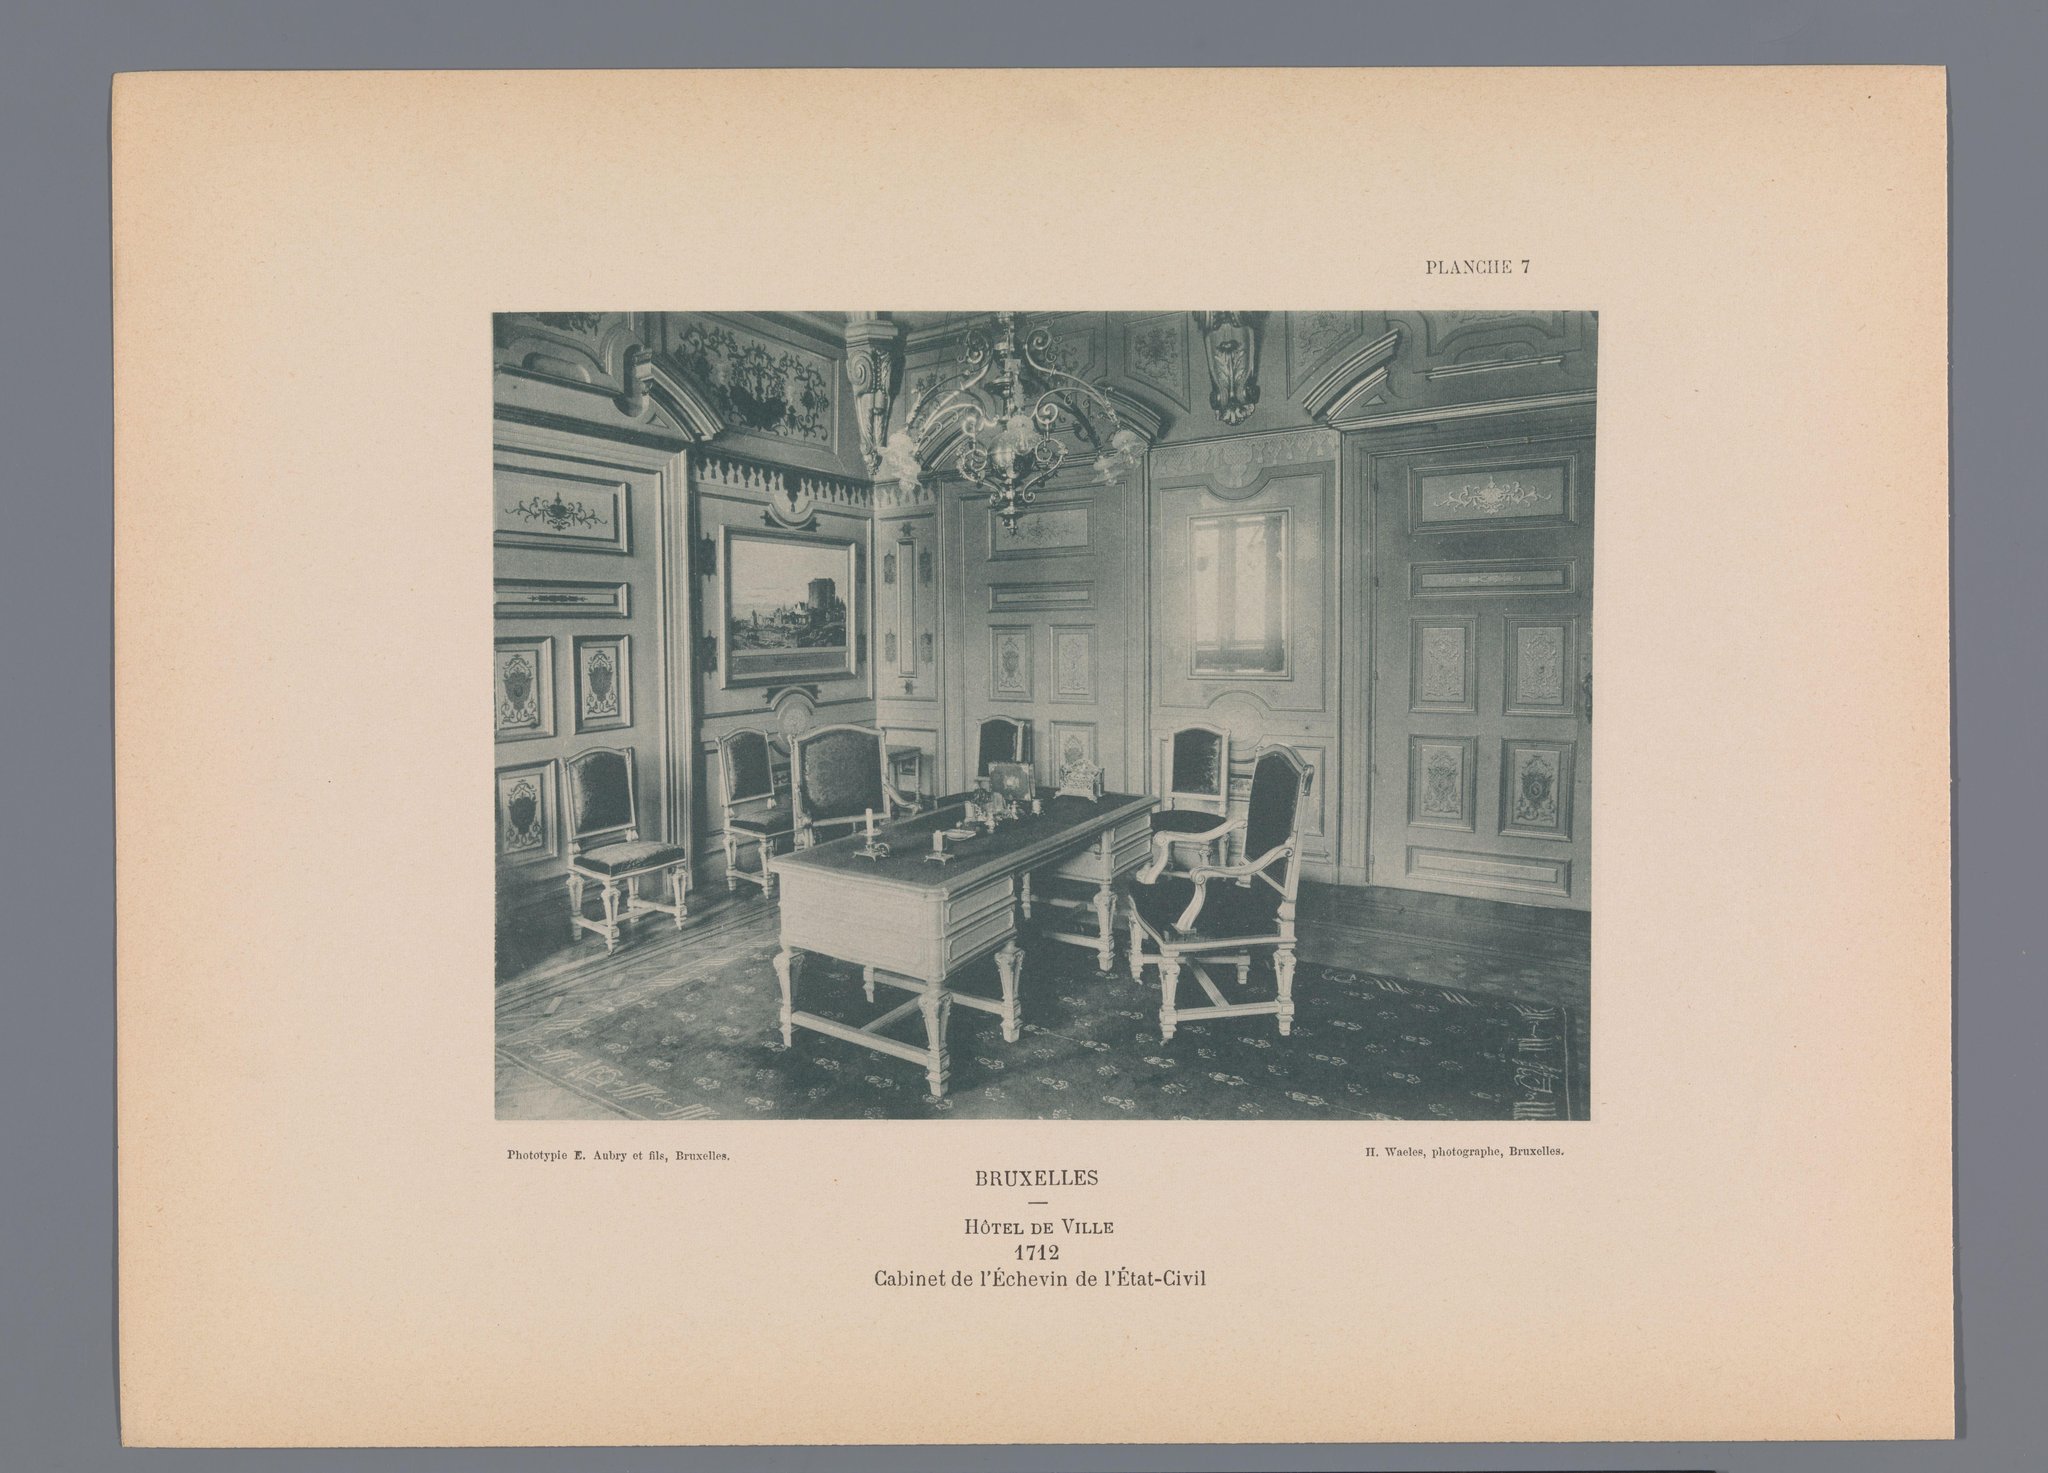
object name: photomechanical print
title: Kantoor van de wethouder van de burgerlijke staat in het stadhuis van Brussel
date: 1893-1898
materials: paper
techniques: photograph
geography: brussels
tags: city council, interior of the house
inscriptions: number: ‘PLANCHE 7’, inscription: ‘Hôtel de Ville/ 1712/ Cabinet de l'Échevinde l'État-Civil’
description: Deze prent maakt deel uit van een omslag met 89 prenten en 5 tekstbladen.